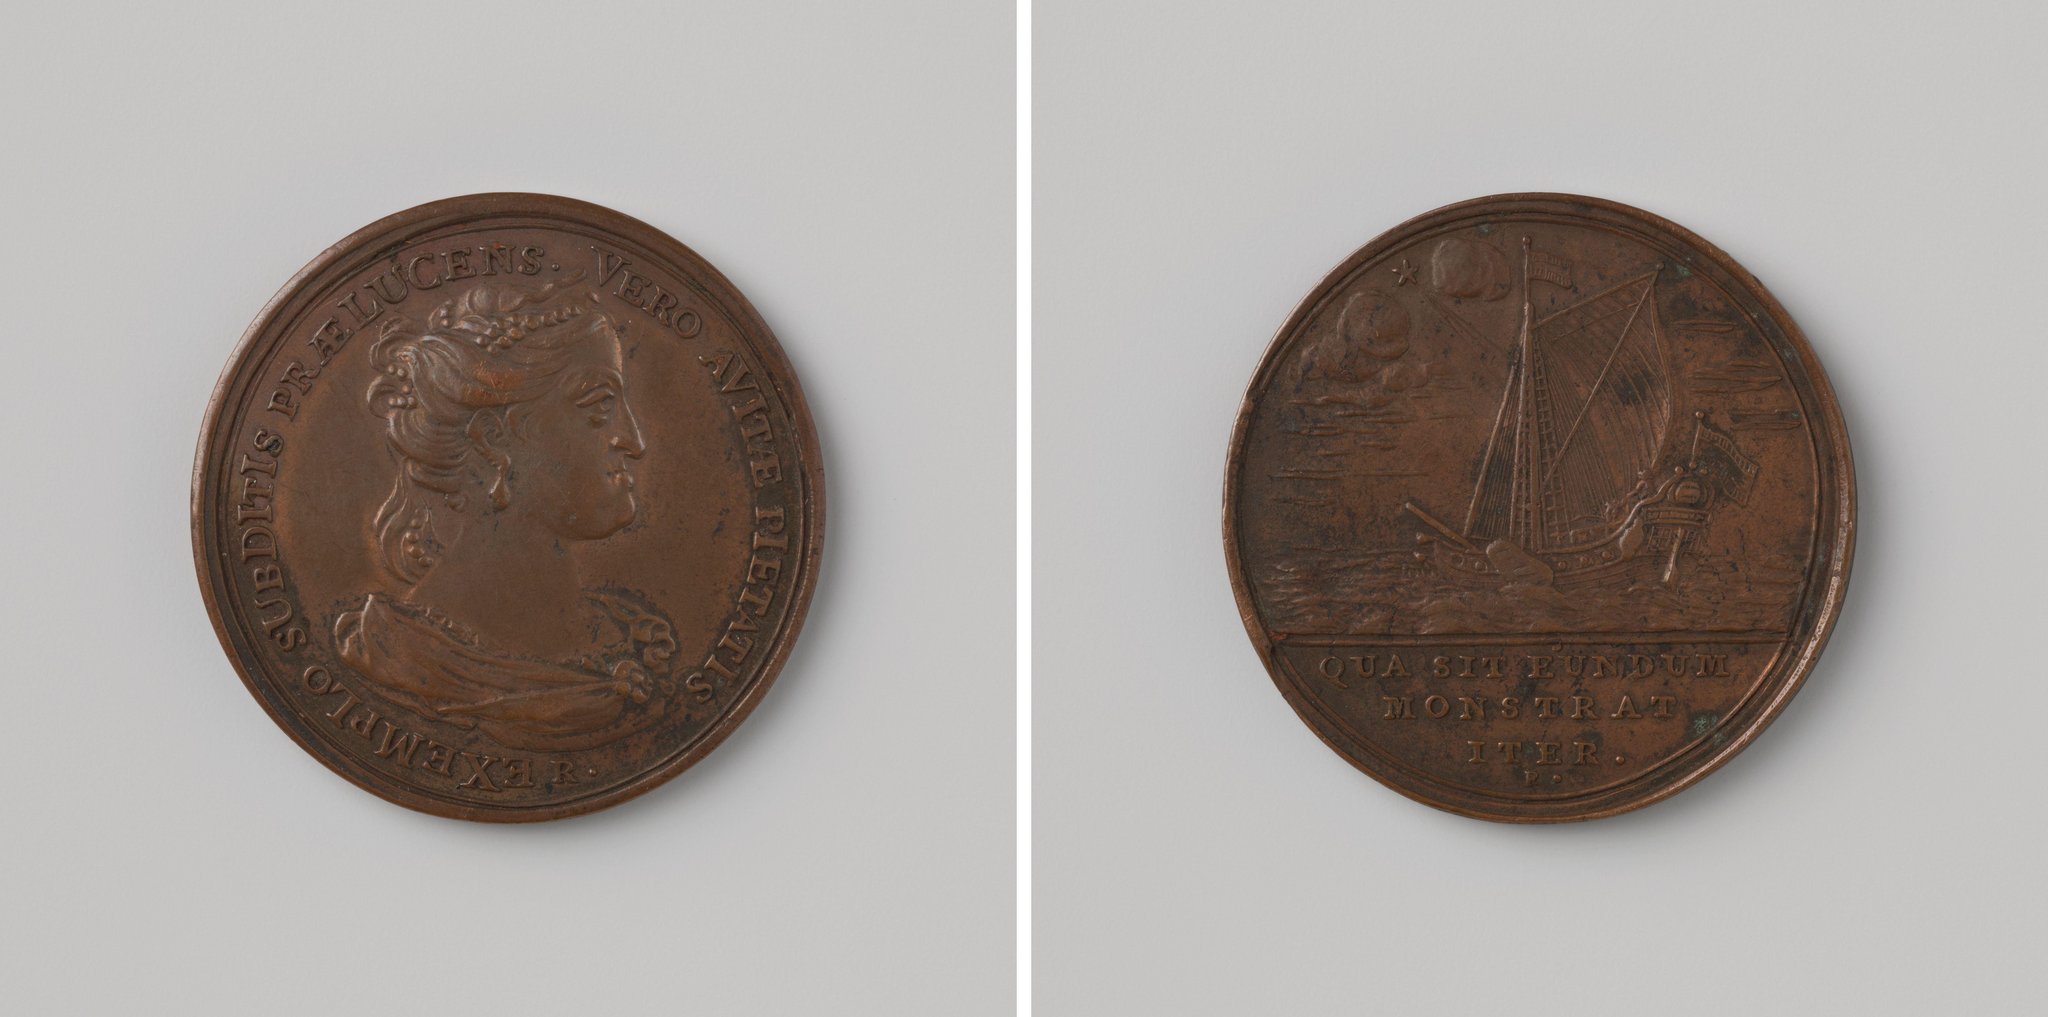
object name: new year medal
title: Maria Elisabeth, landvoogdes der zuidelijke Nederlanden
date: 1735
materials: bronze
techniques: striking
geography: antwerp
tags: landvoogd, maria elisabeth (aartshertogin van oostenrijk)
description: Bronzen penning. Voorzijde: borststuk vrouw met diadeem binnen omschrift. Keerzijde: schip, dat in richting van poolster vaart binnen omschrift; afsnede: opschrift